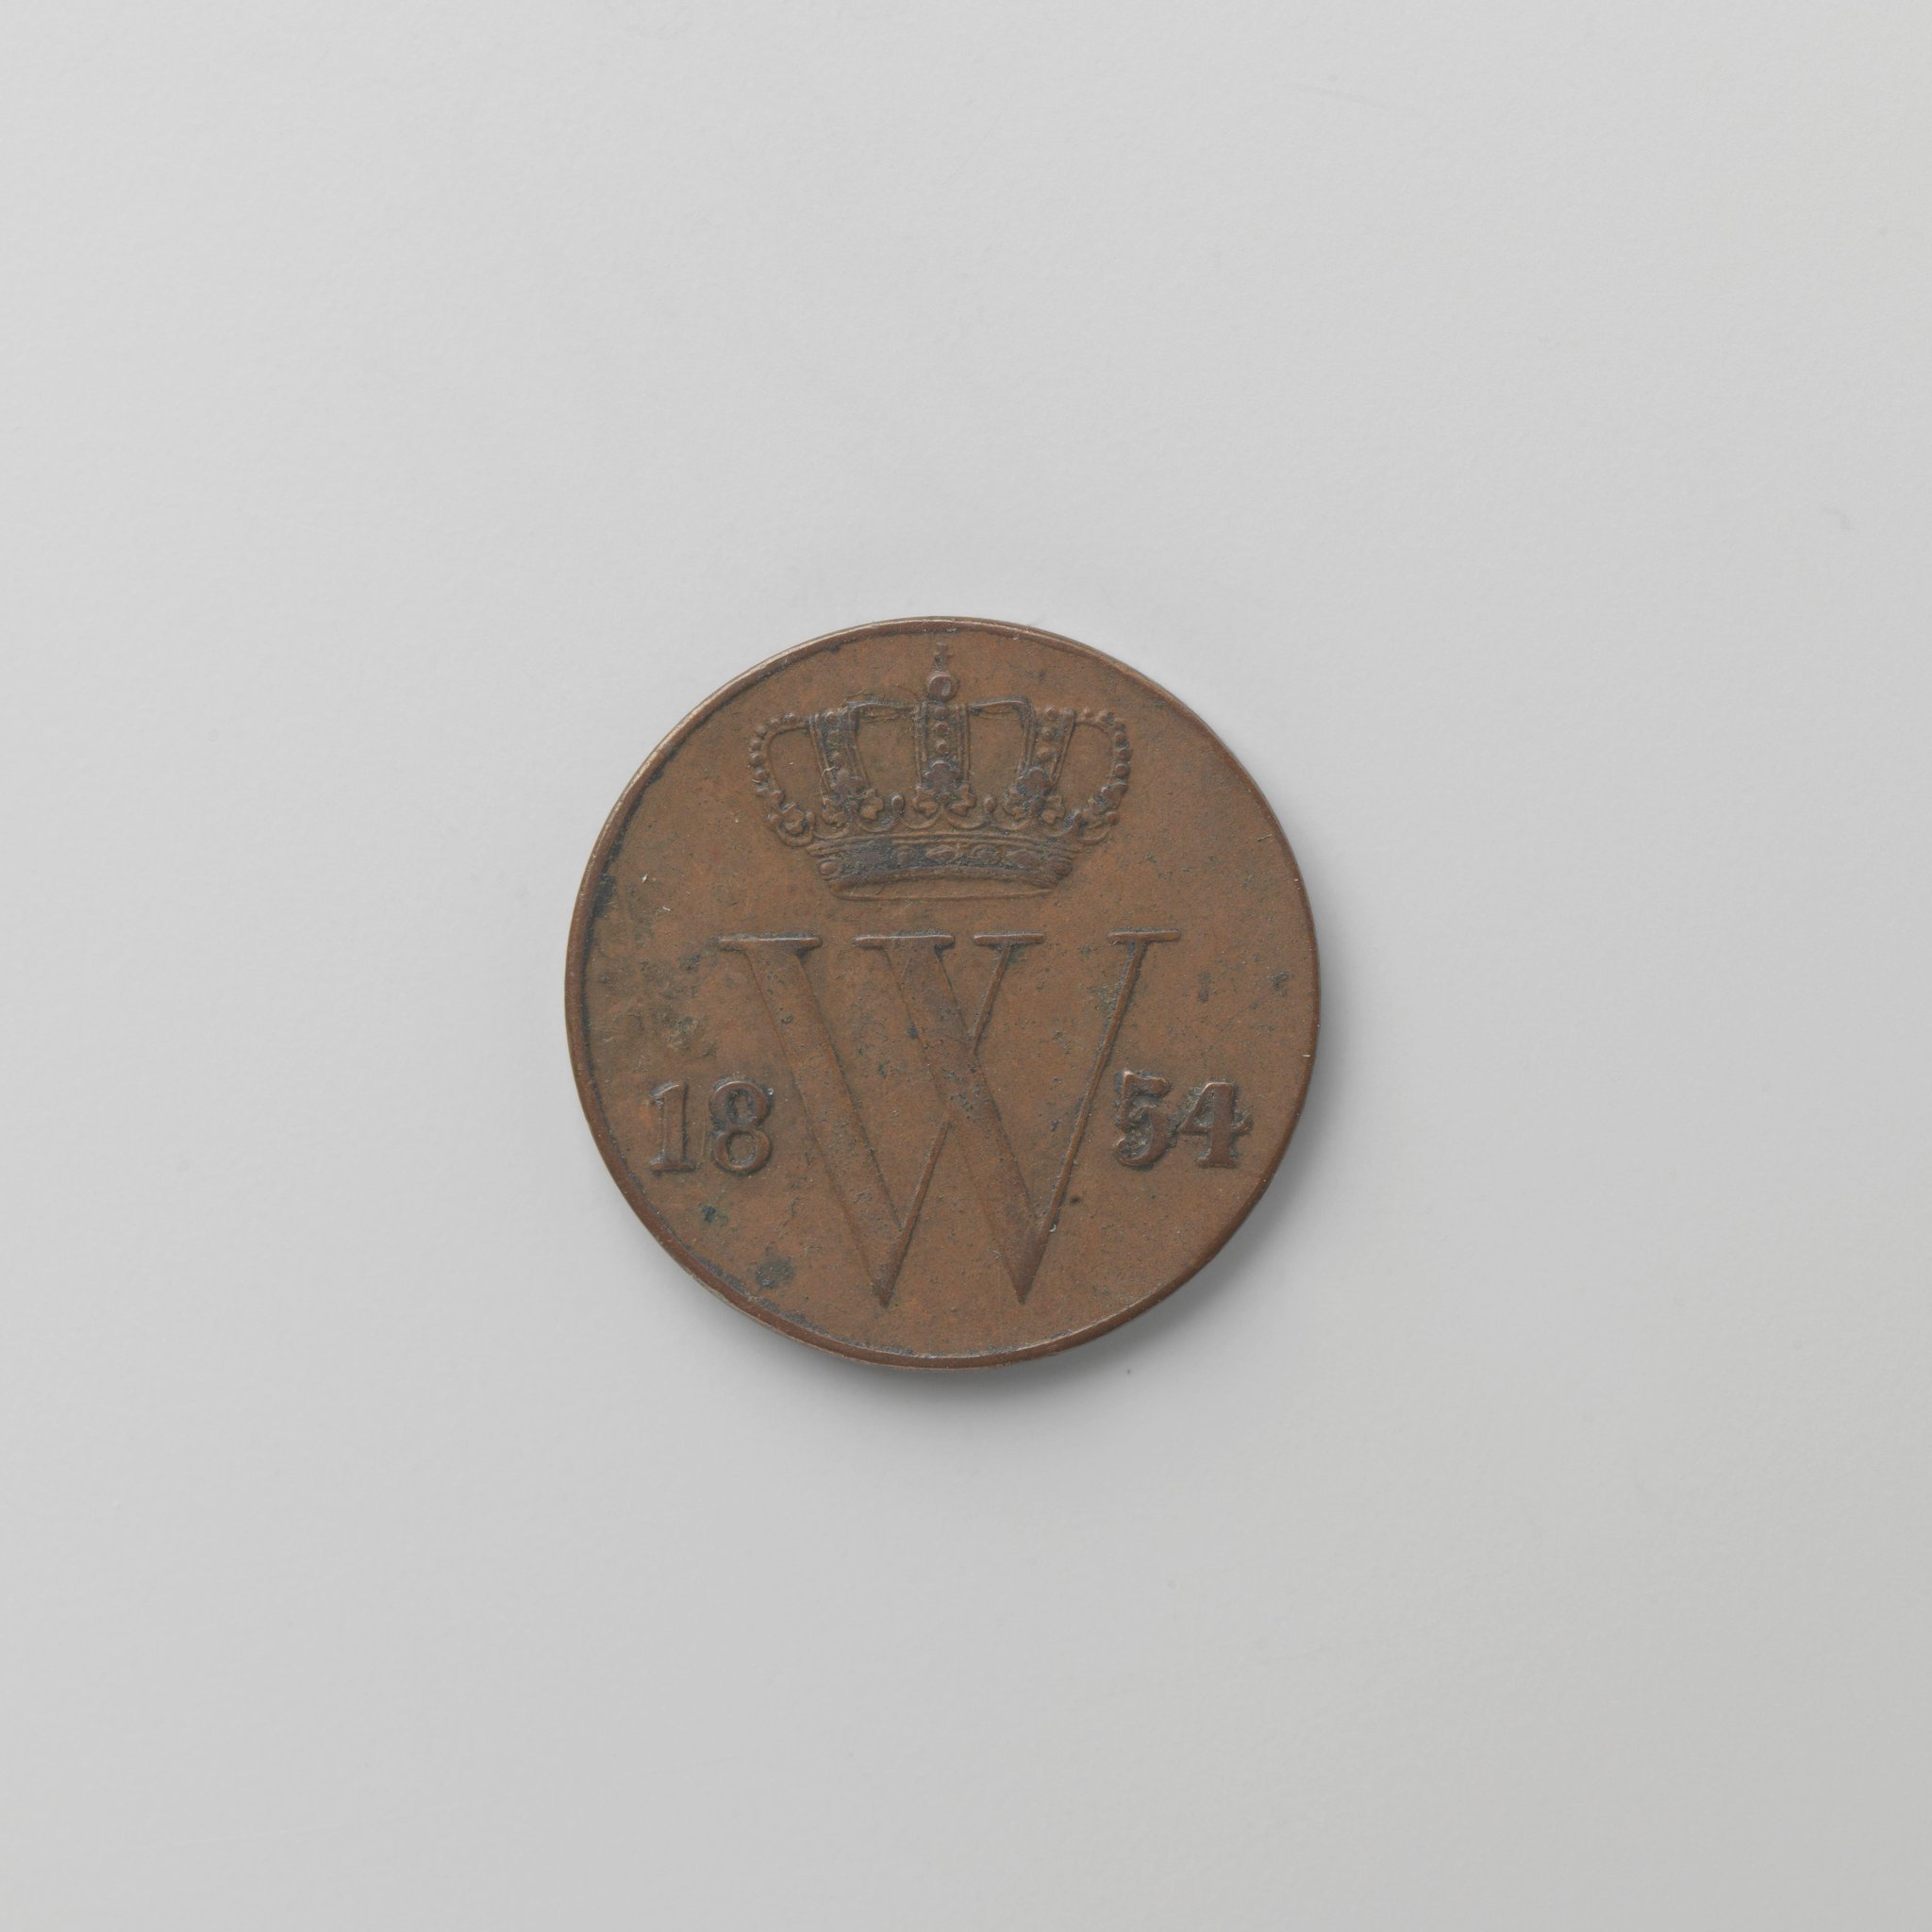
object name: coin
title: Nederland, ½ cent, 1854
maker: willem iii (koning der nederlanden)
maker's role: koning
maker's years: 1817-1890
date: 1854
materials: copper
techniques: striking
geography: utrecht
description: Koperen munt. Voorzijde: tussen jaartal gekroonde rechte letter W. Keerzijde: tussen waarde-aanduiding ½ C. gekroond rijkswapenschild. Gladde rand.